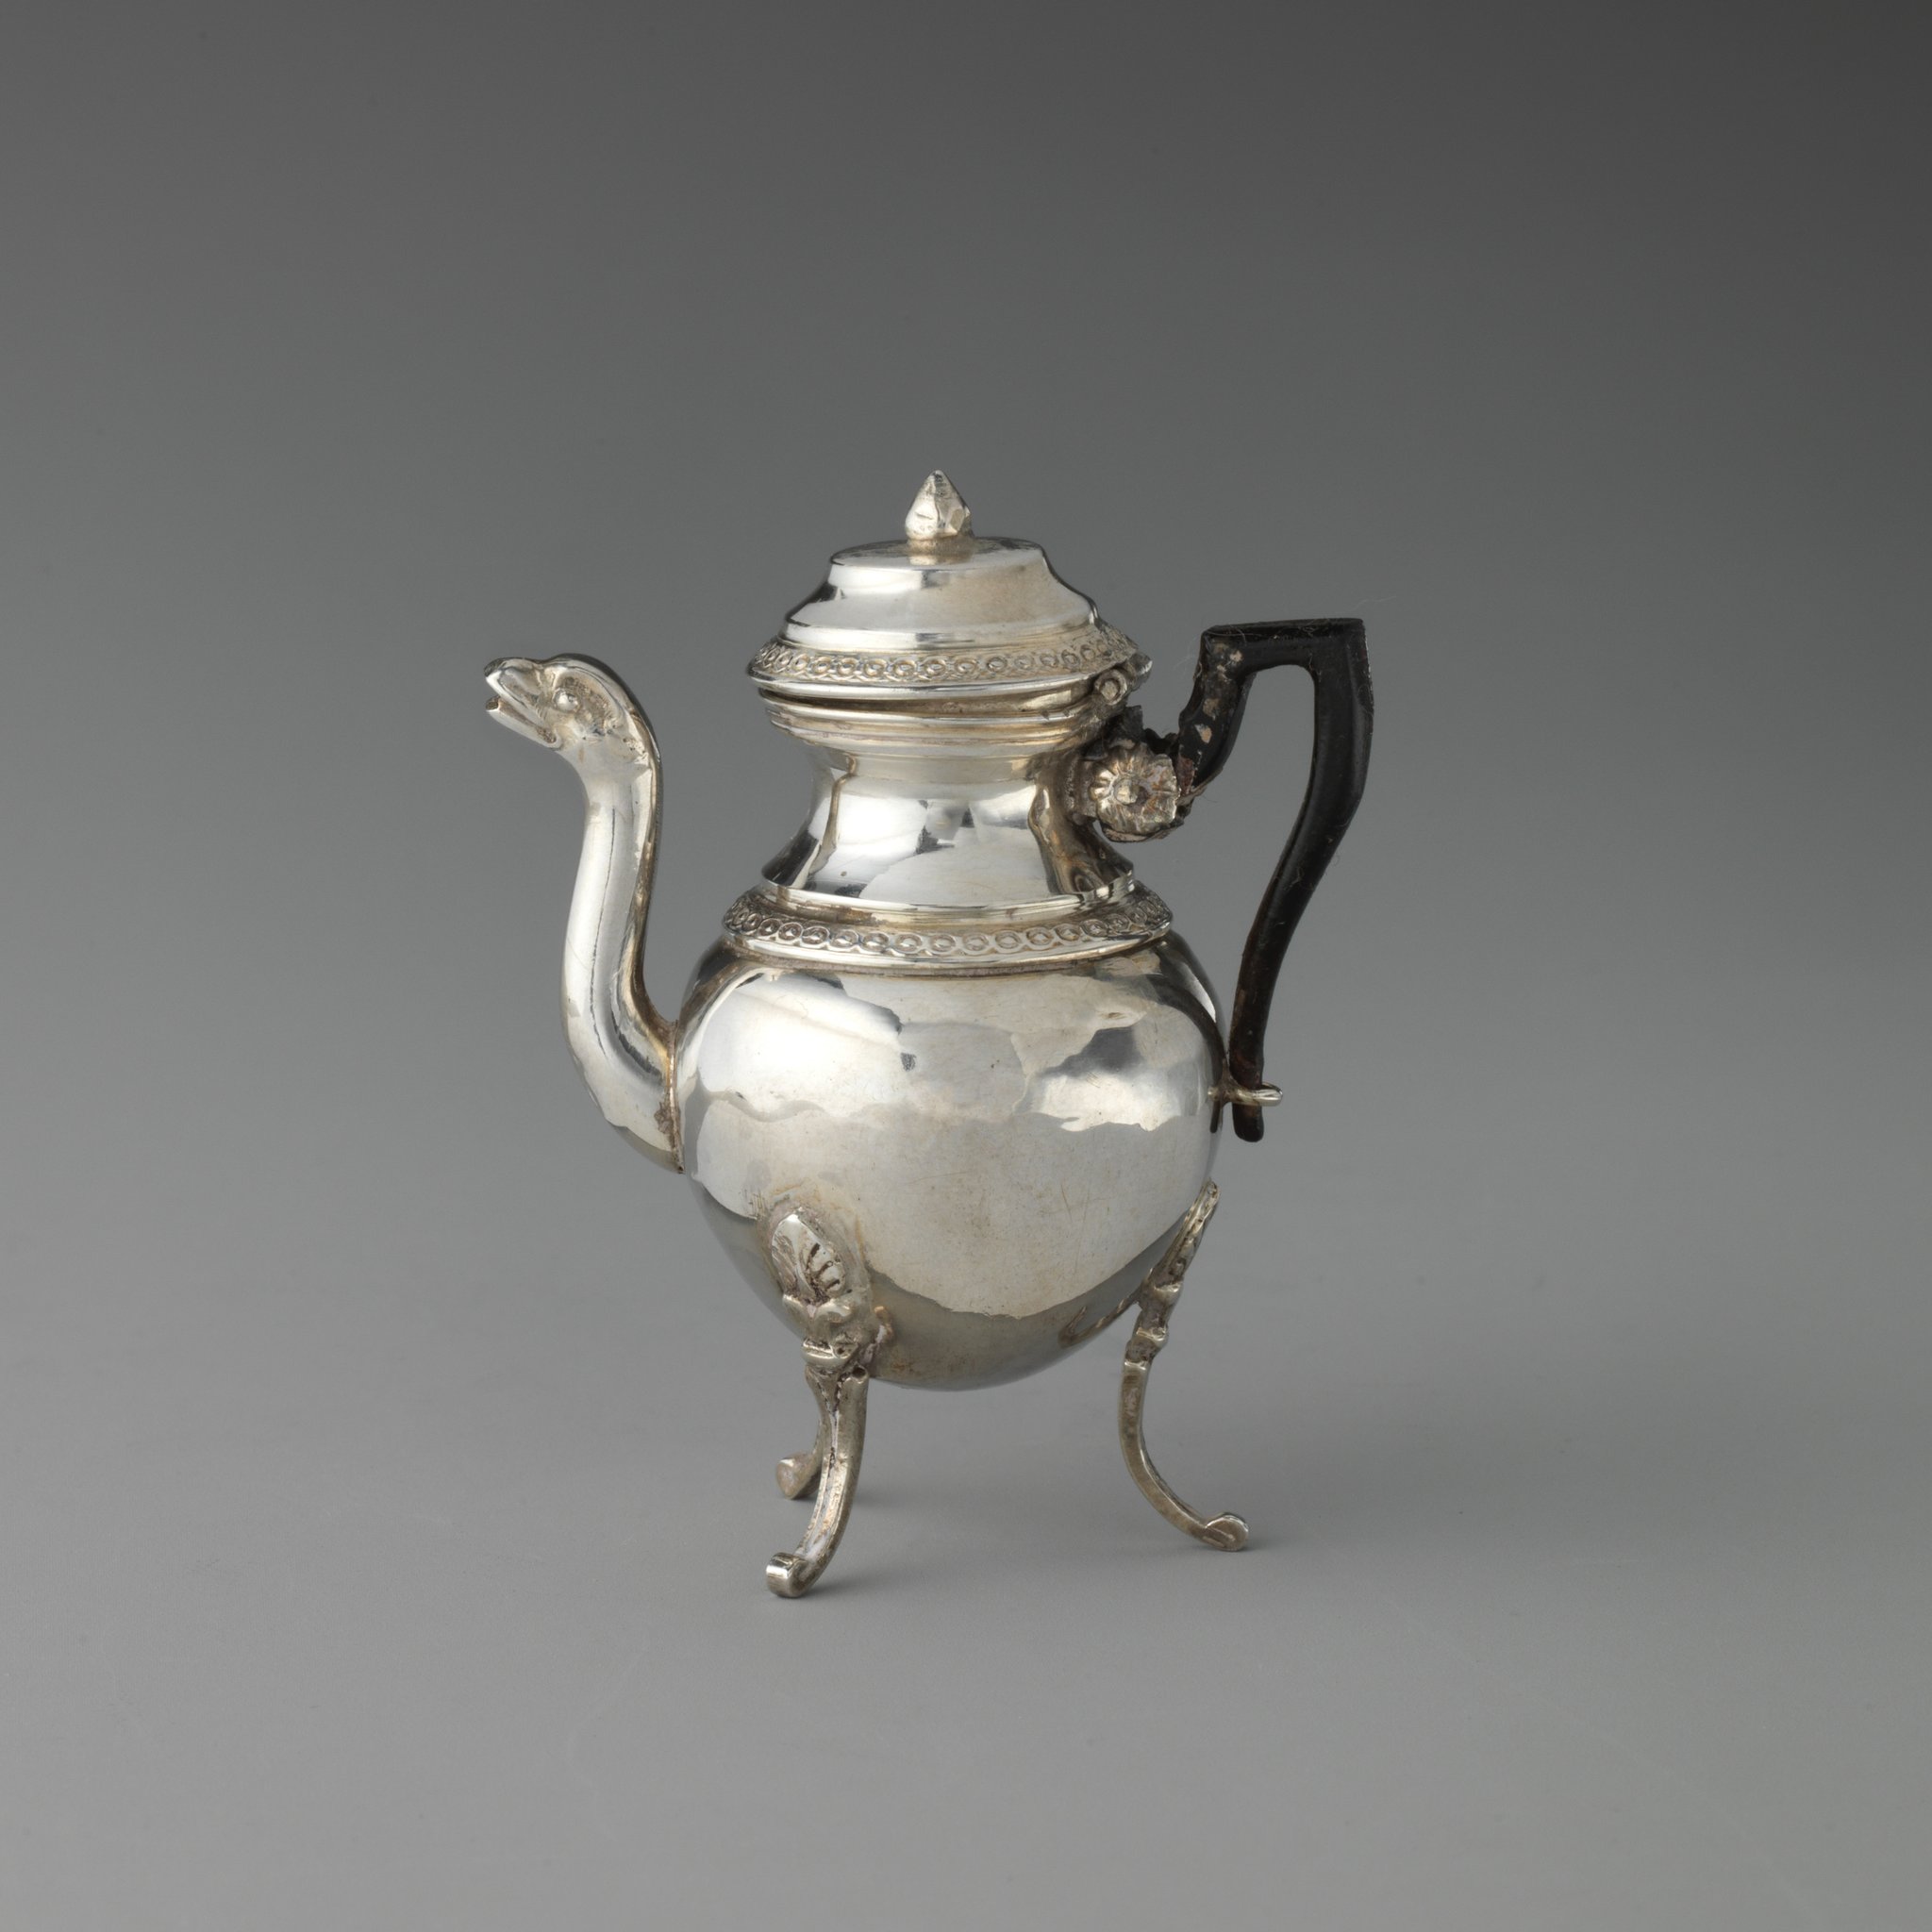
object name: teapot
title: Miniature teapot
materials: silver, wood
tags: birds